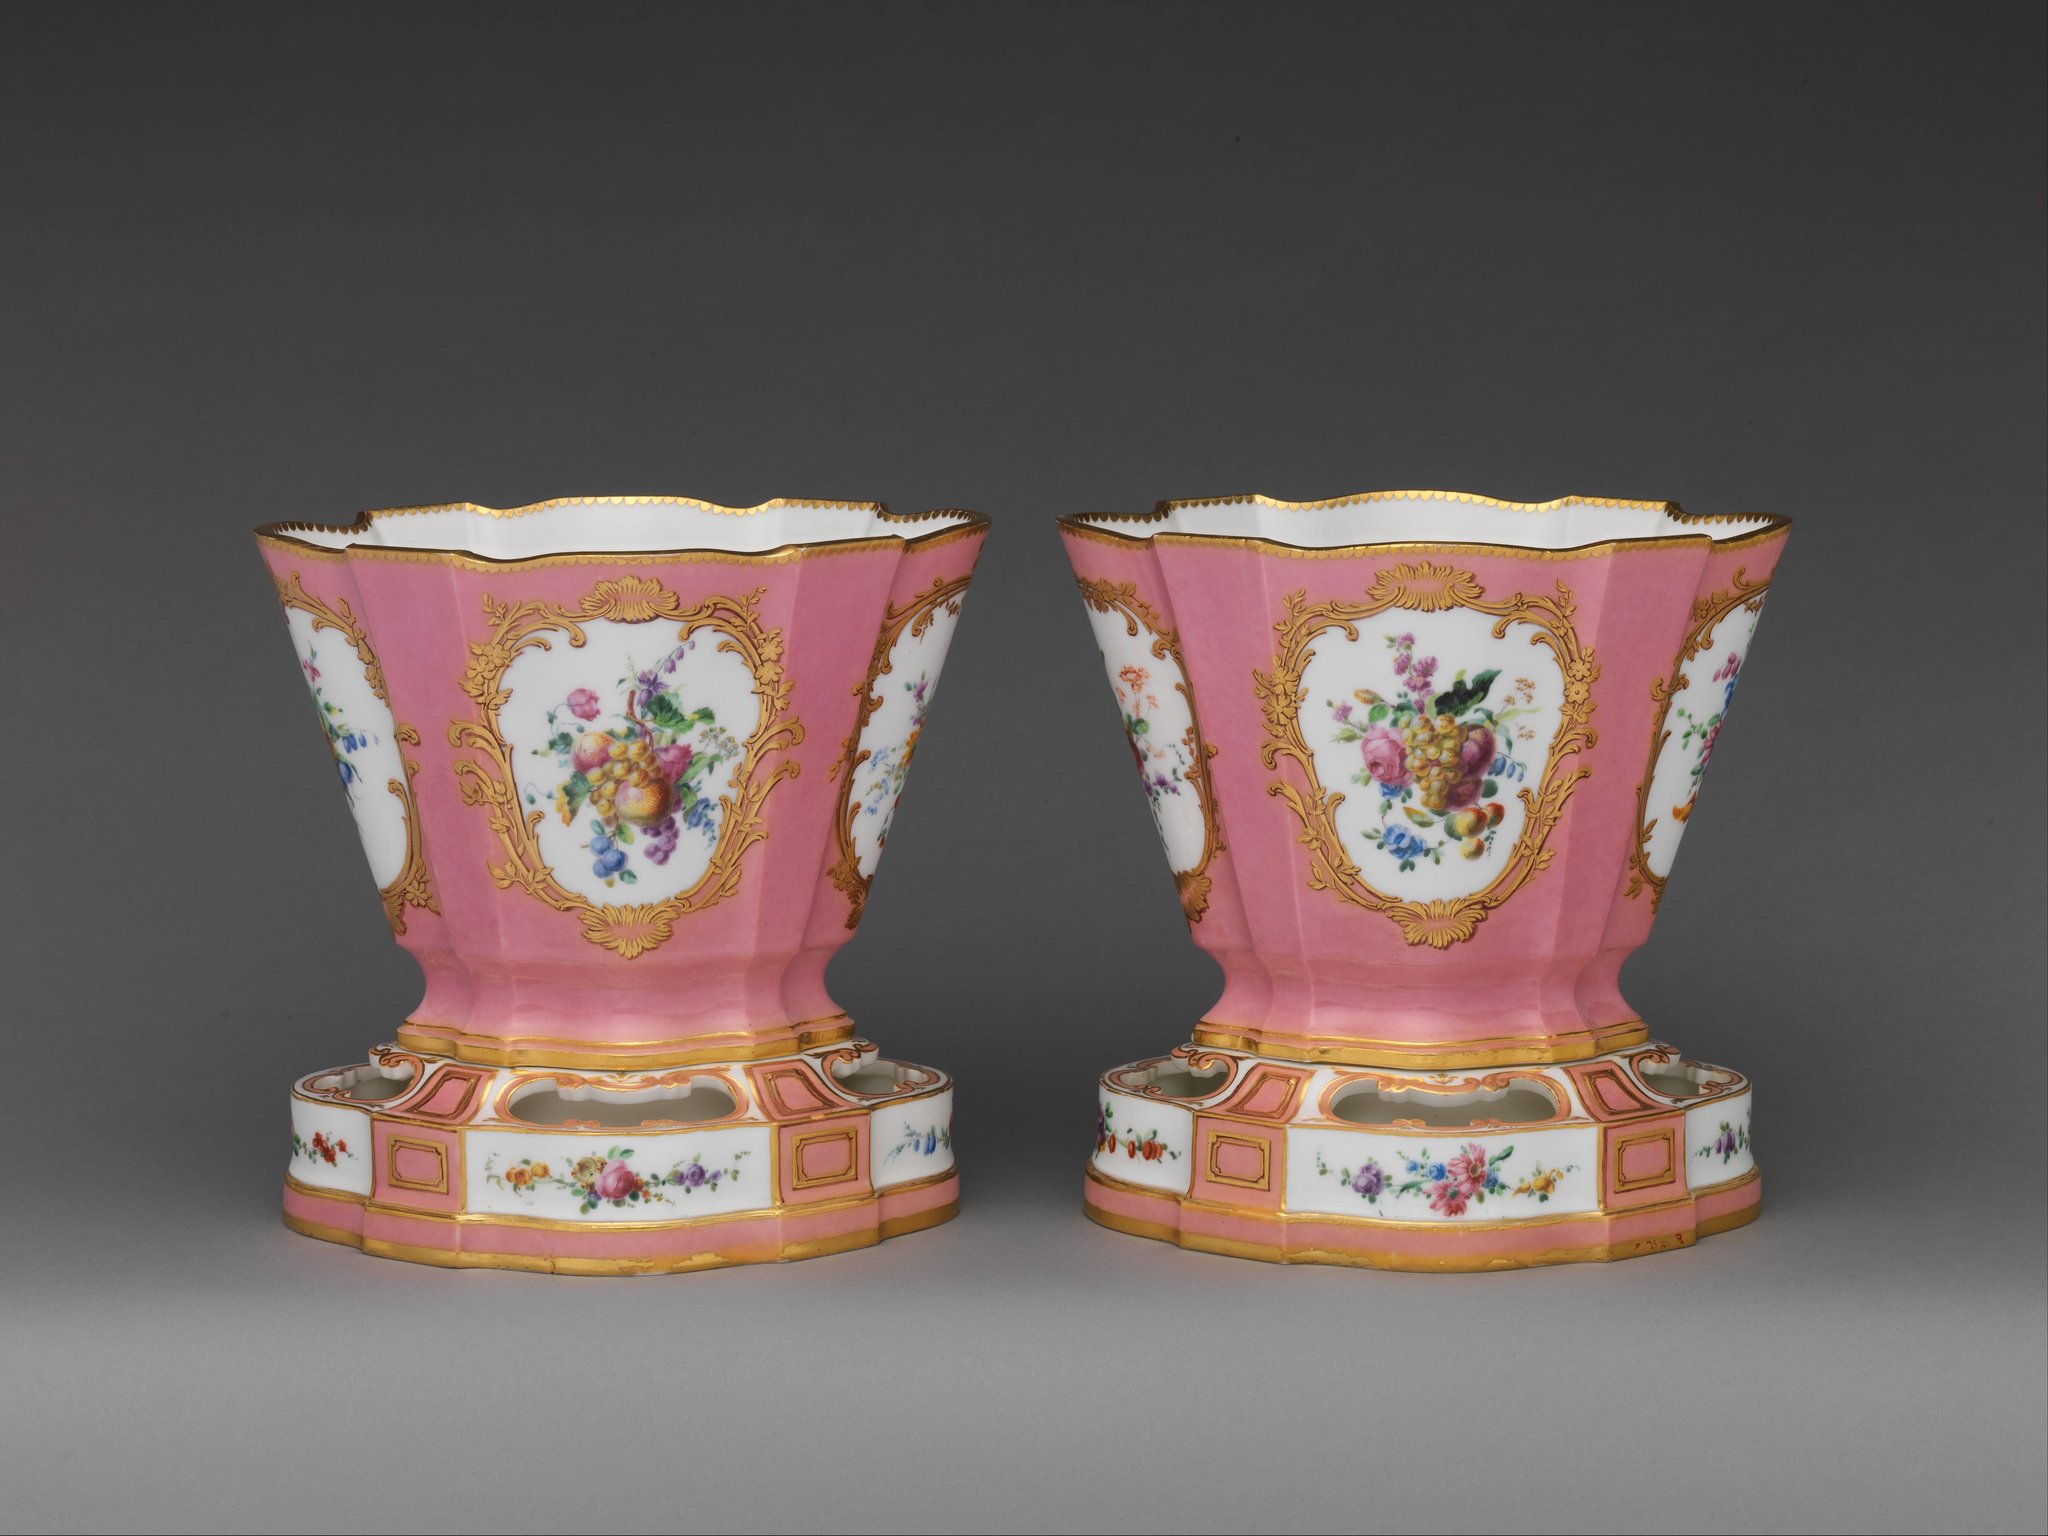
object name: flower vase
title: Pair of flower vases (vases hollandois)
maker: sèvres manufactory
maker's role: manufactory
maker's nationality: french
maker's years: 1740-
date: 1758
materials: soft paste porcelain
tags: fruit,flowers